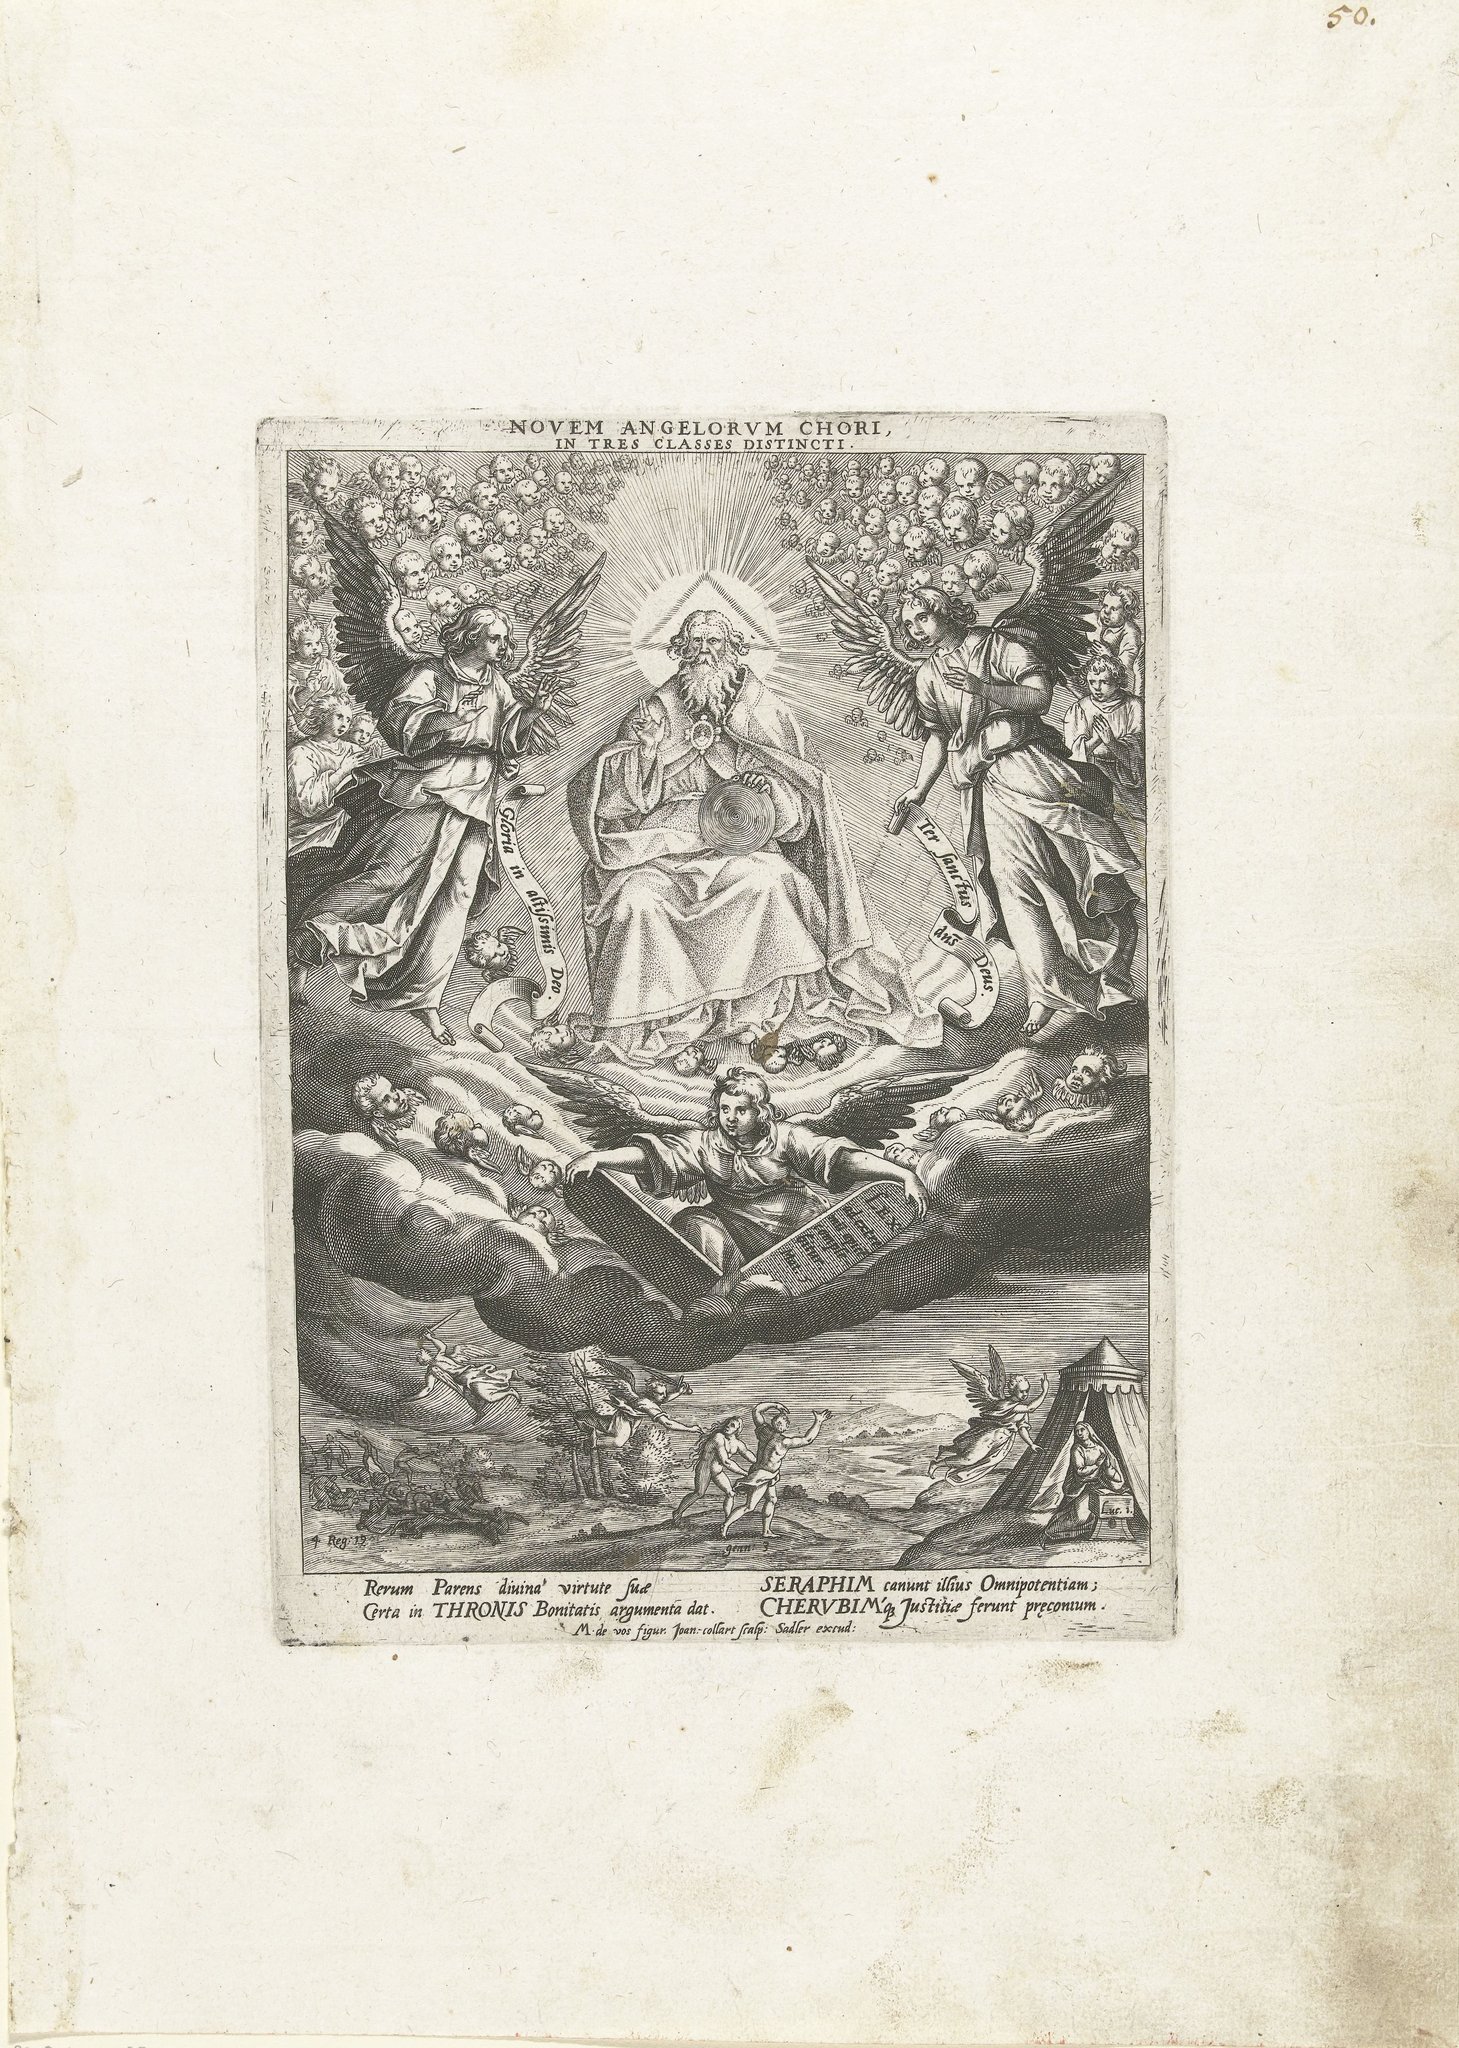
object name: print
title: Engelenkoren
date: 1576-1628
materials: paper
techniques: engraving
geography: antwerp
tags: cherubs, i.e. children's heads with wings, the annunciation: mary kneeling, at night, an angel of the lord decimates the assyrian camp: 185.000 soldiers are killed, an angel chases adam and eve out of paradise with a (flaming) sword, thrones (holding thrones) ~ hierarchy of angels, seraphim (+ god the father)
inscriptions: collector's mark: Lugt 2228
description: God de vader in de wolken. Rondom Hem drie groepen engelen: serafijnen, cherubijnen en tronen. Onder God houdt een engel de twee stenen tafels vast met de wet van Mozes. Onder de wolken de daden van deze engelen op aarde: in het midden de verdrijving uit het Paradijs, links de vernietiging van het legerkamp van de Assyriërs en rechts de Annunciatie. De prent heeft een Latijns onderschrift en maakt deel uit van een serie over de verschillende engelenkoren.